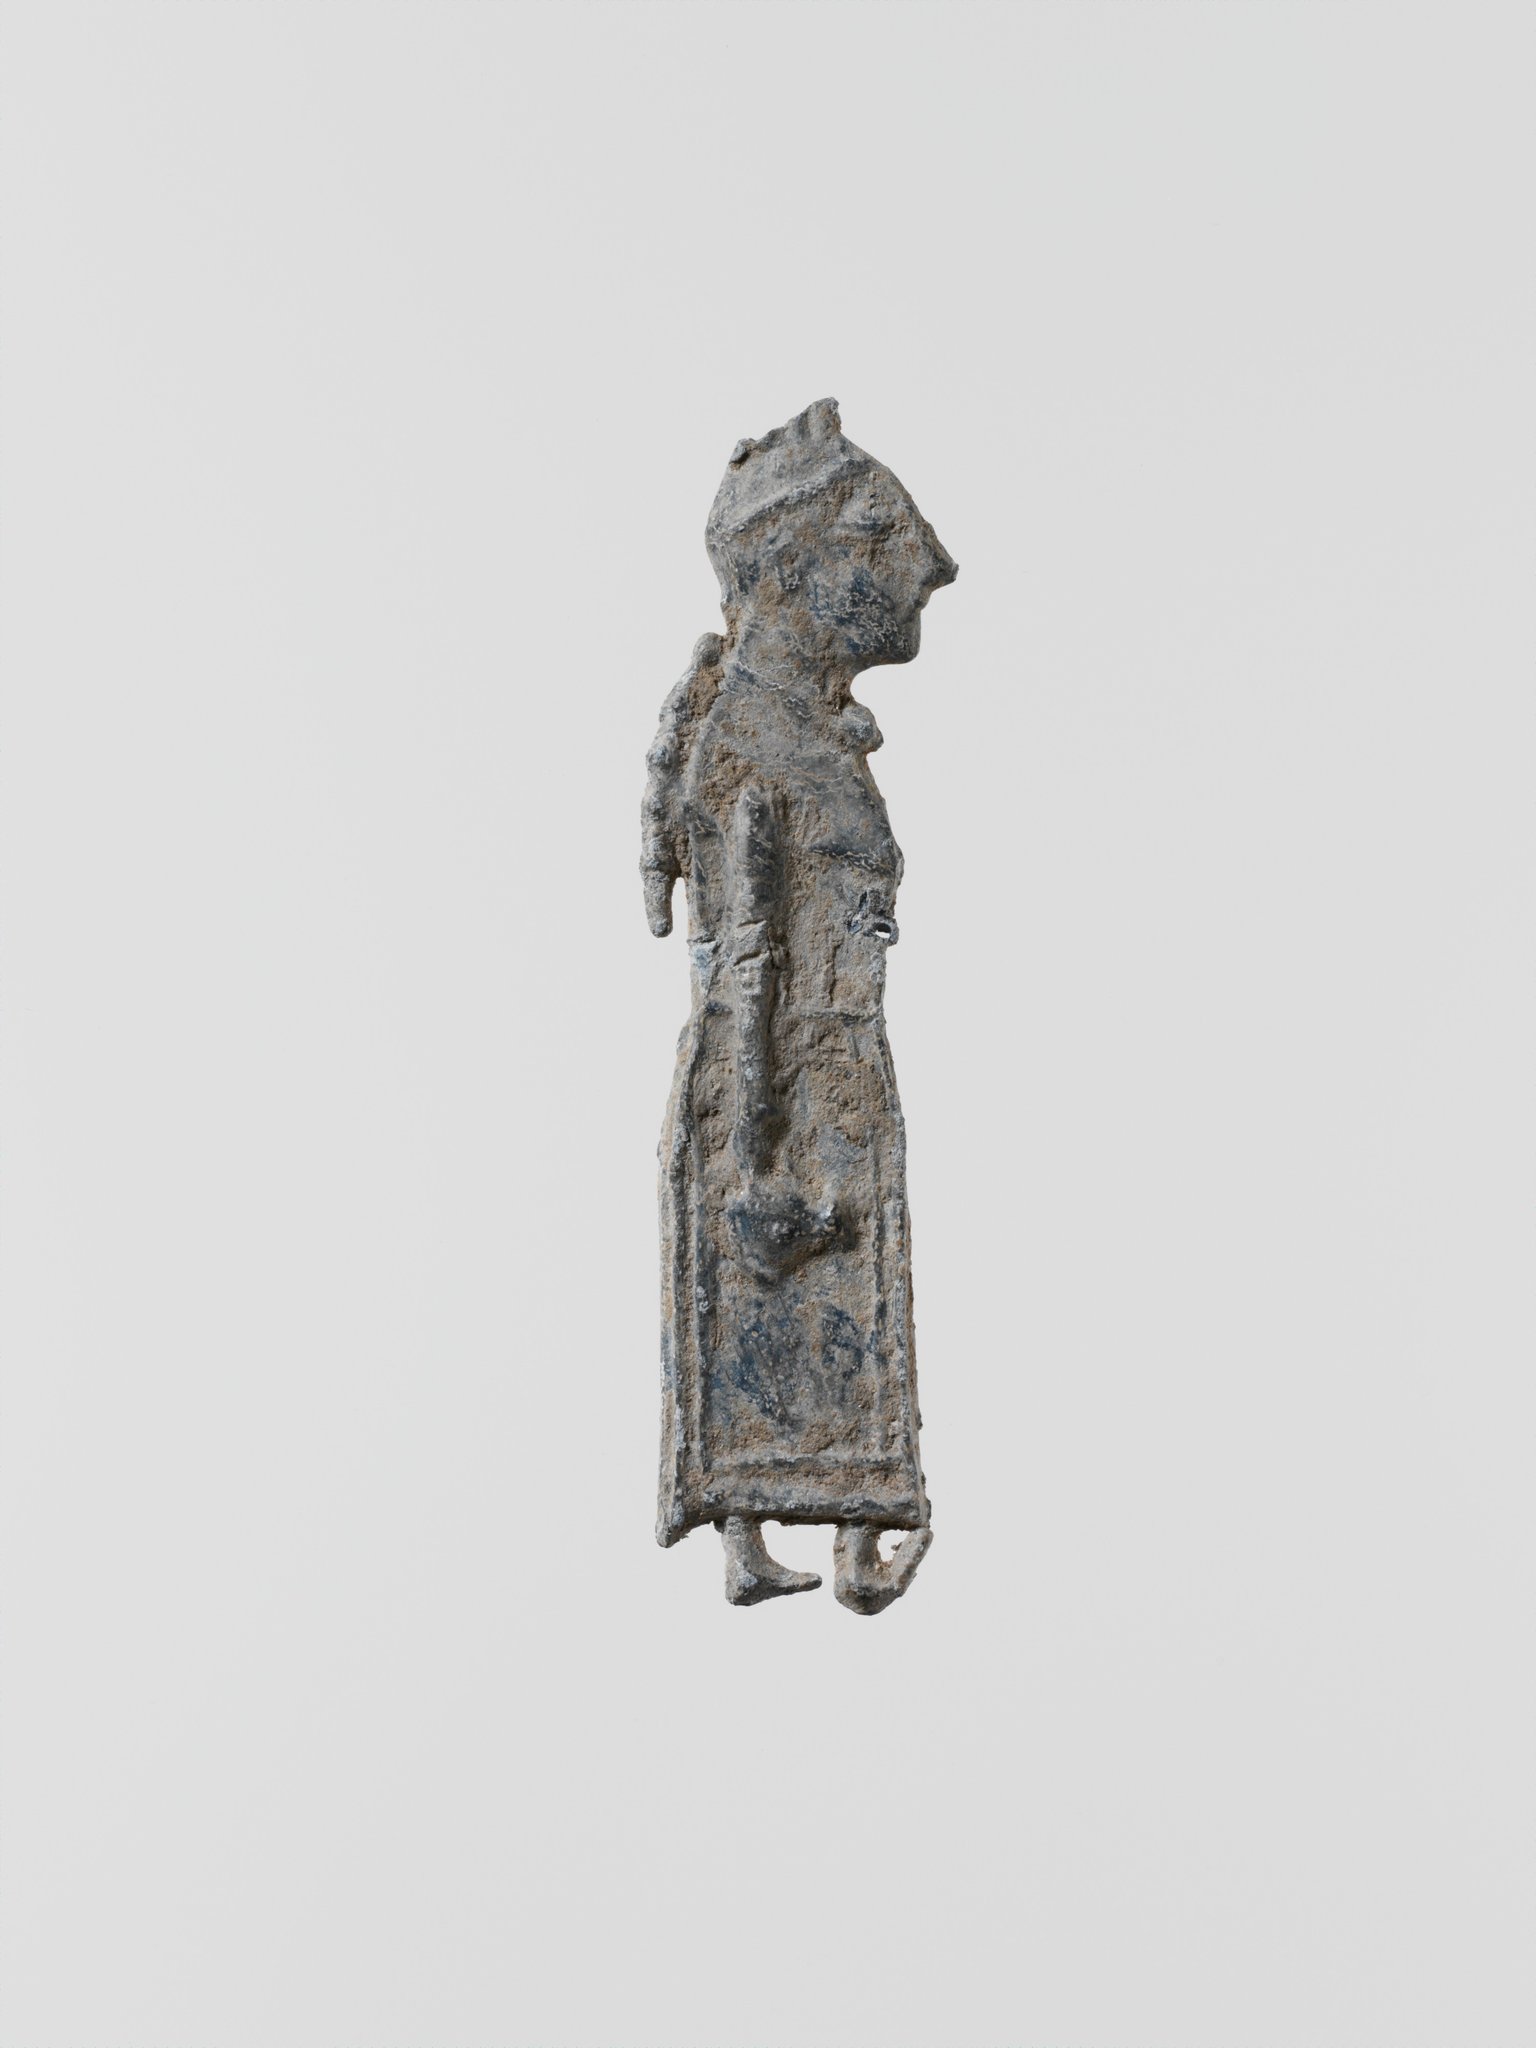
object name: statuette of a woman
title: Lead figure of a woman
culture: greek, laconian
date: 634-568 BCE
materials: lead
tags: women